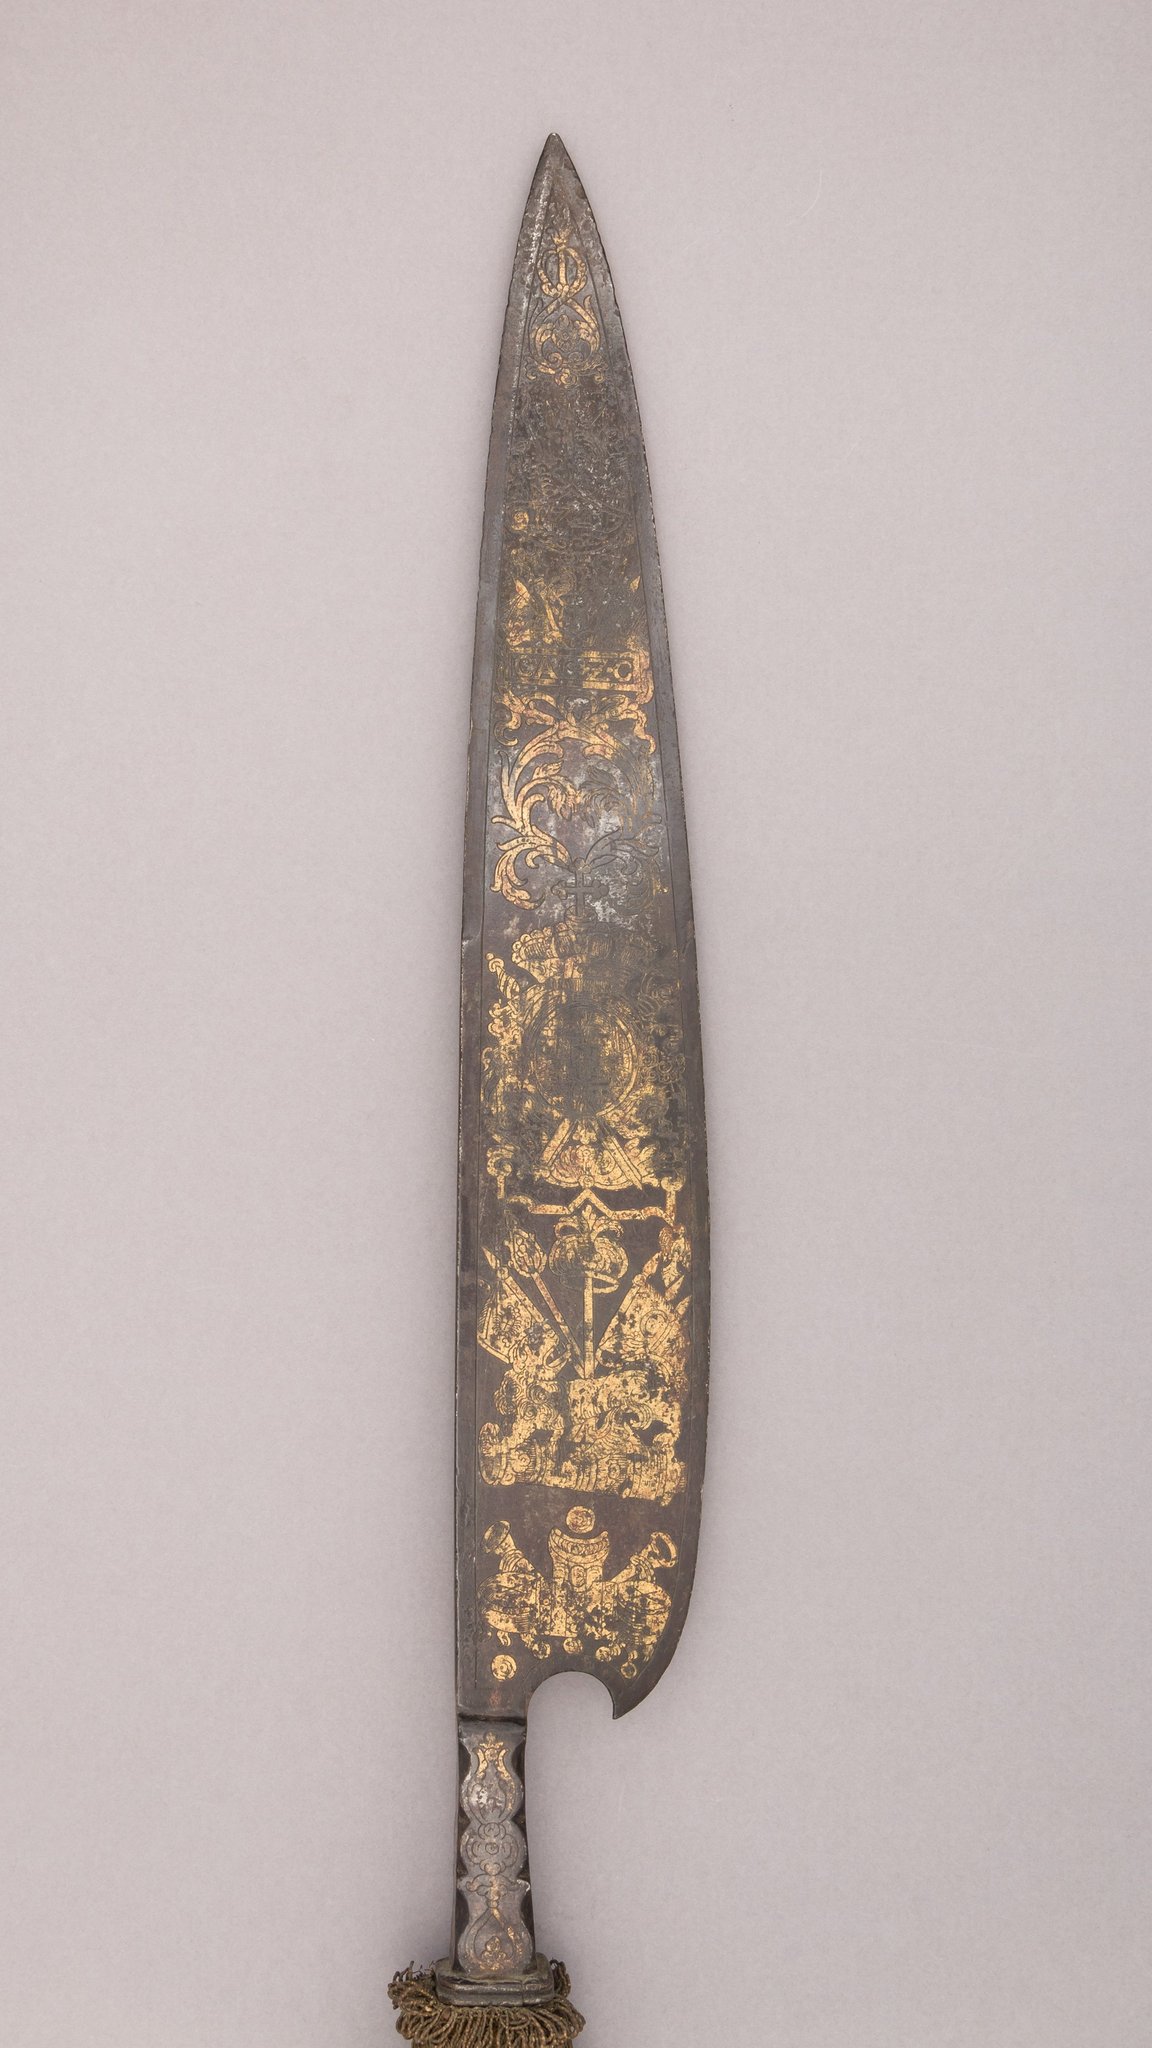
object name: staff weapon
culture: german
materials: copper alloy, gold, metal thread, steel, textile, wood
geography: germany